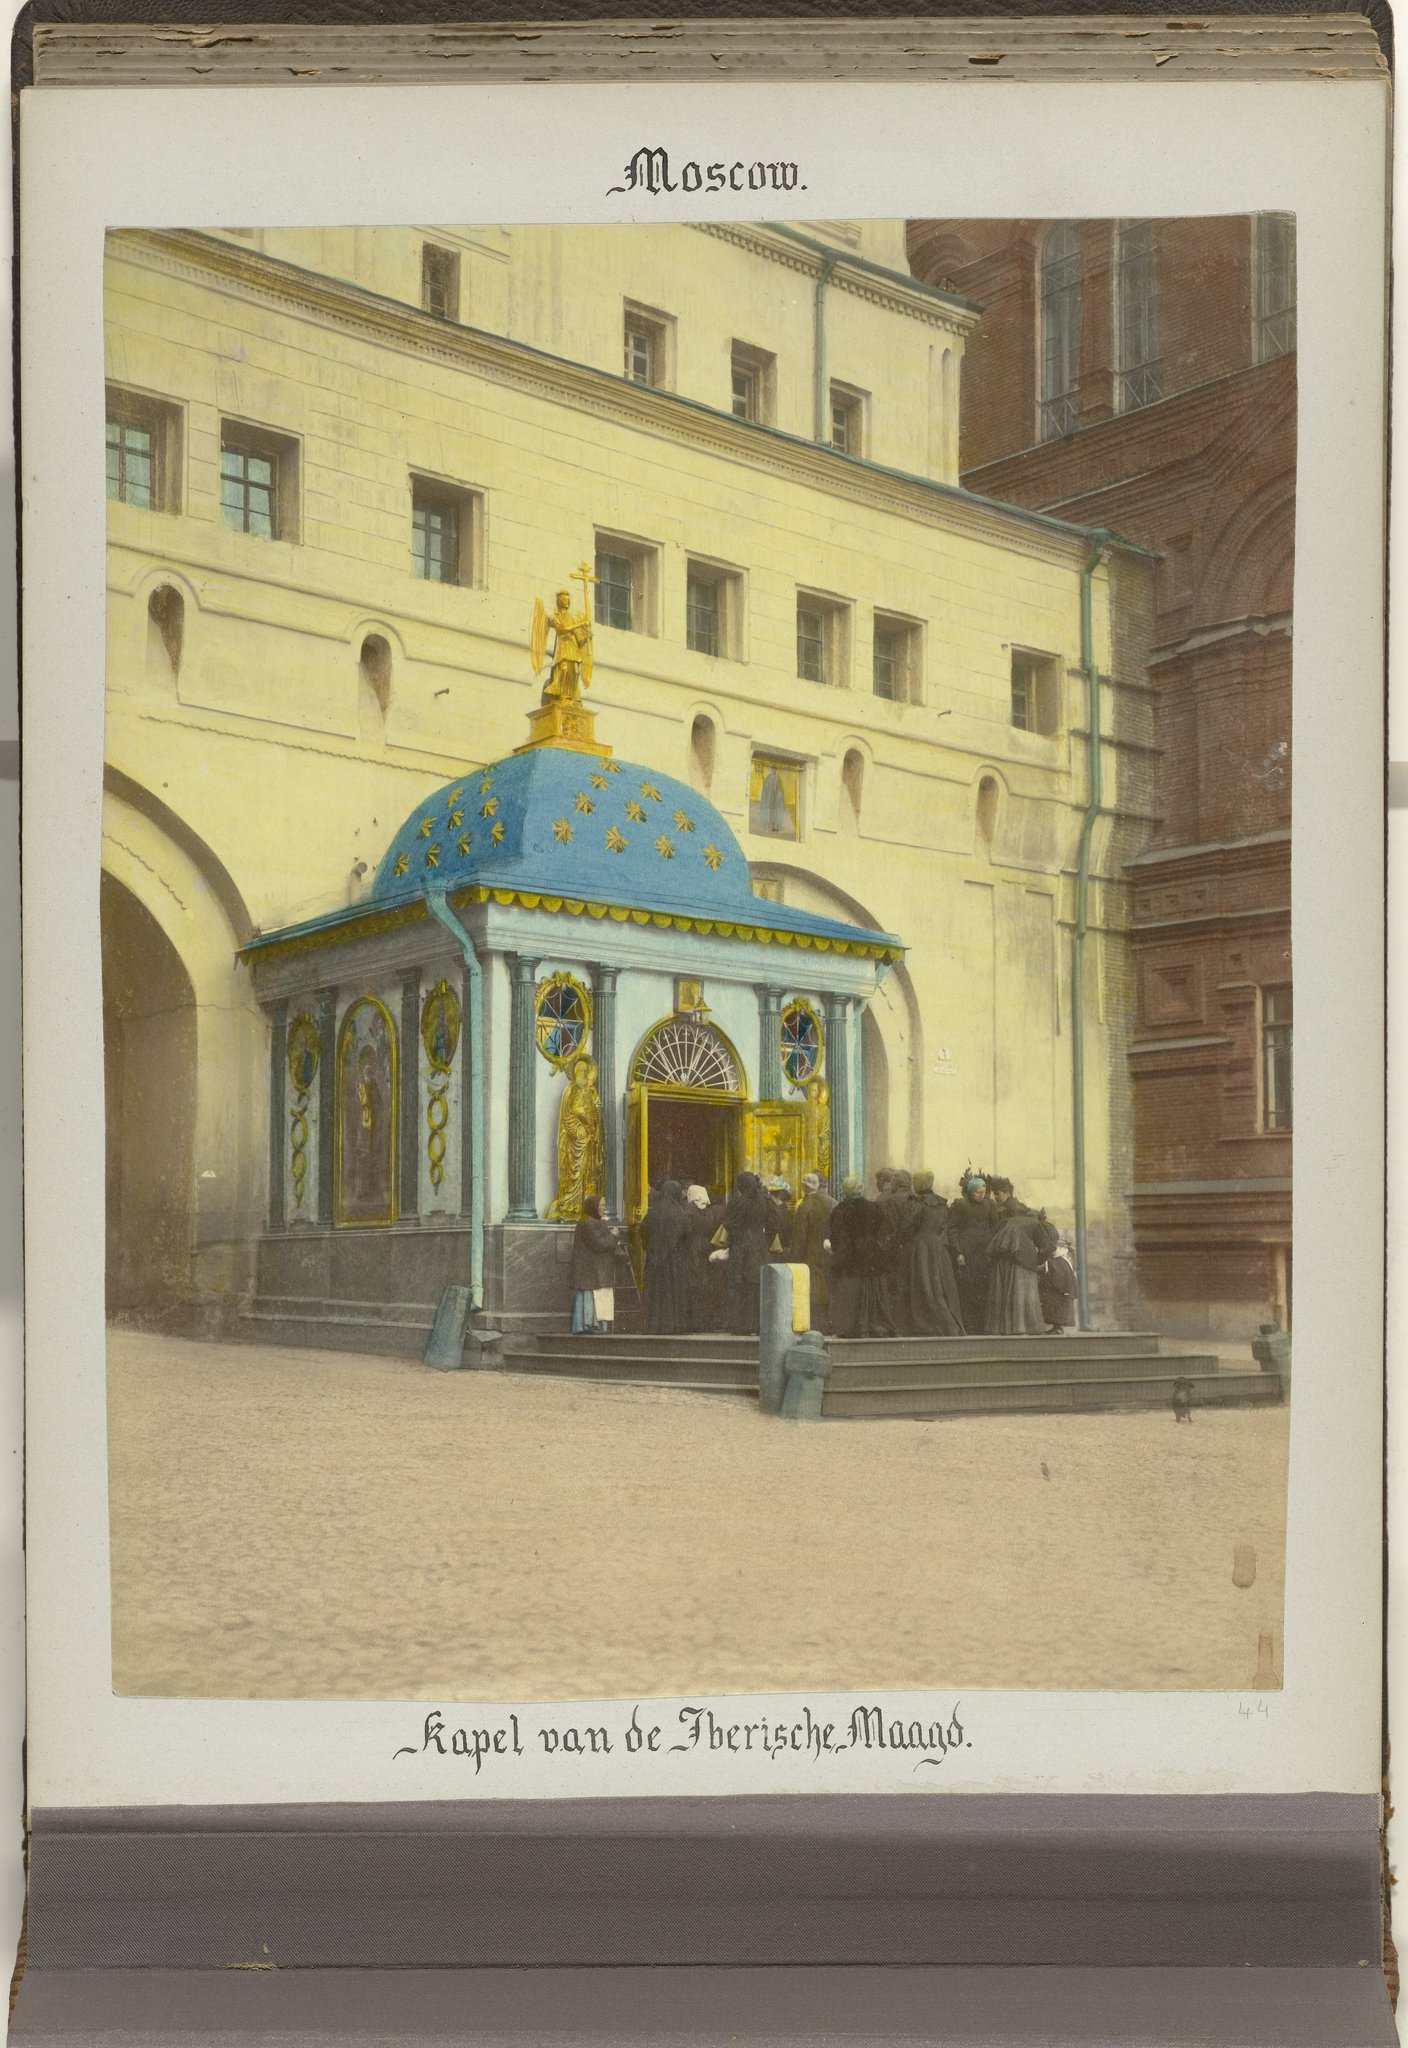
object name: photograph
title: Moscow, Kapel van de Iberische maagd.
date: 1898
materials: paper, photographic support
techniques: albumen print